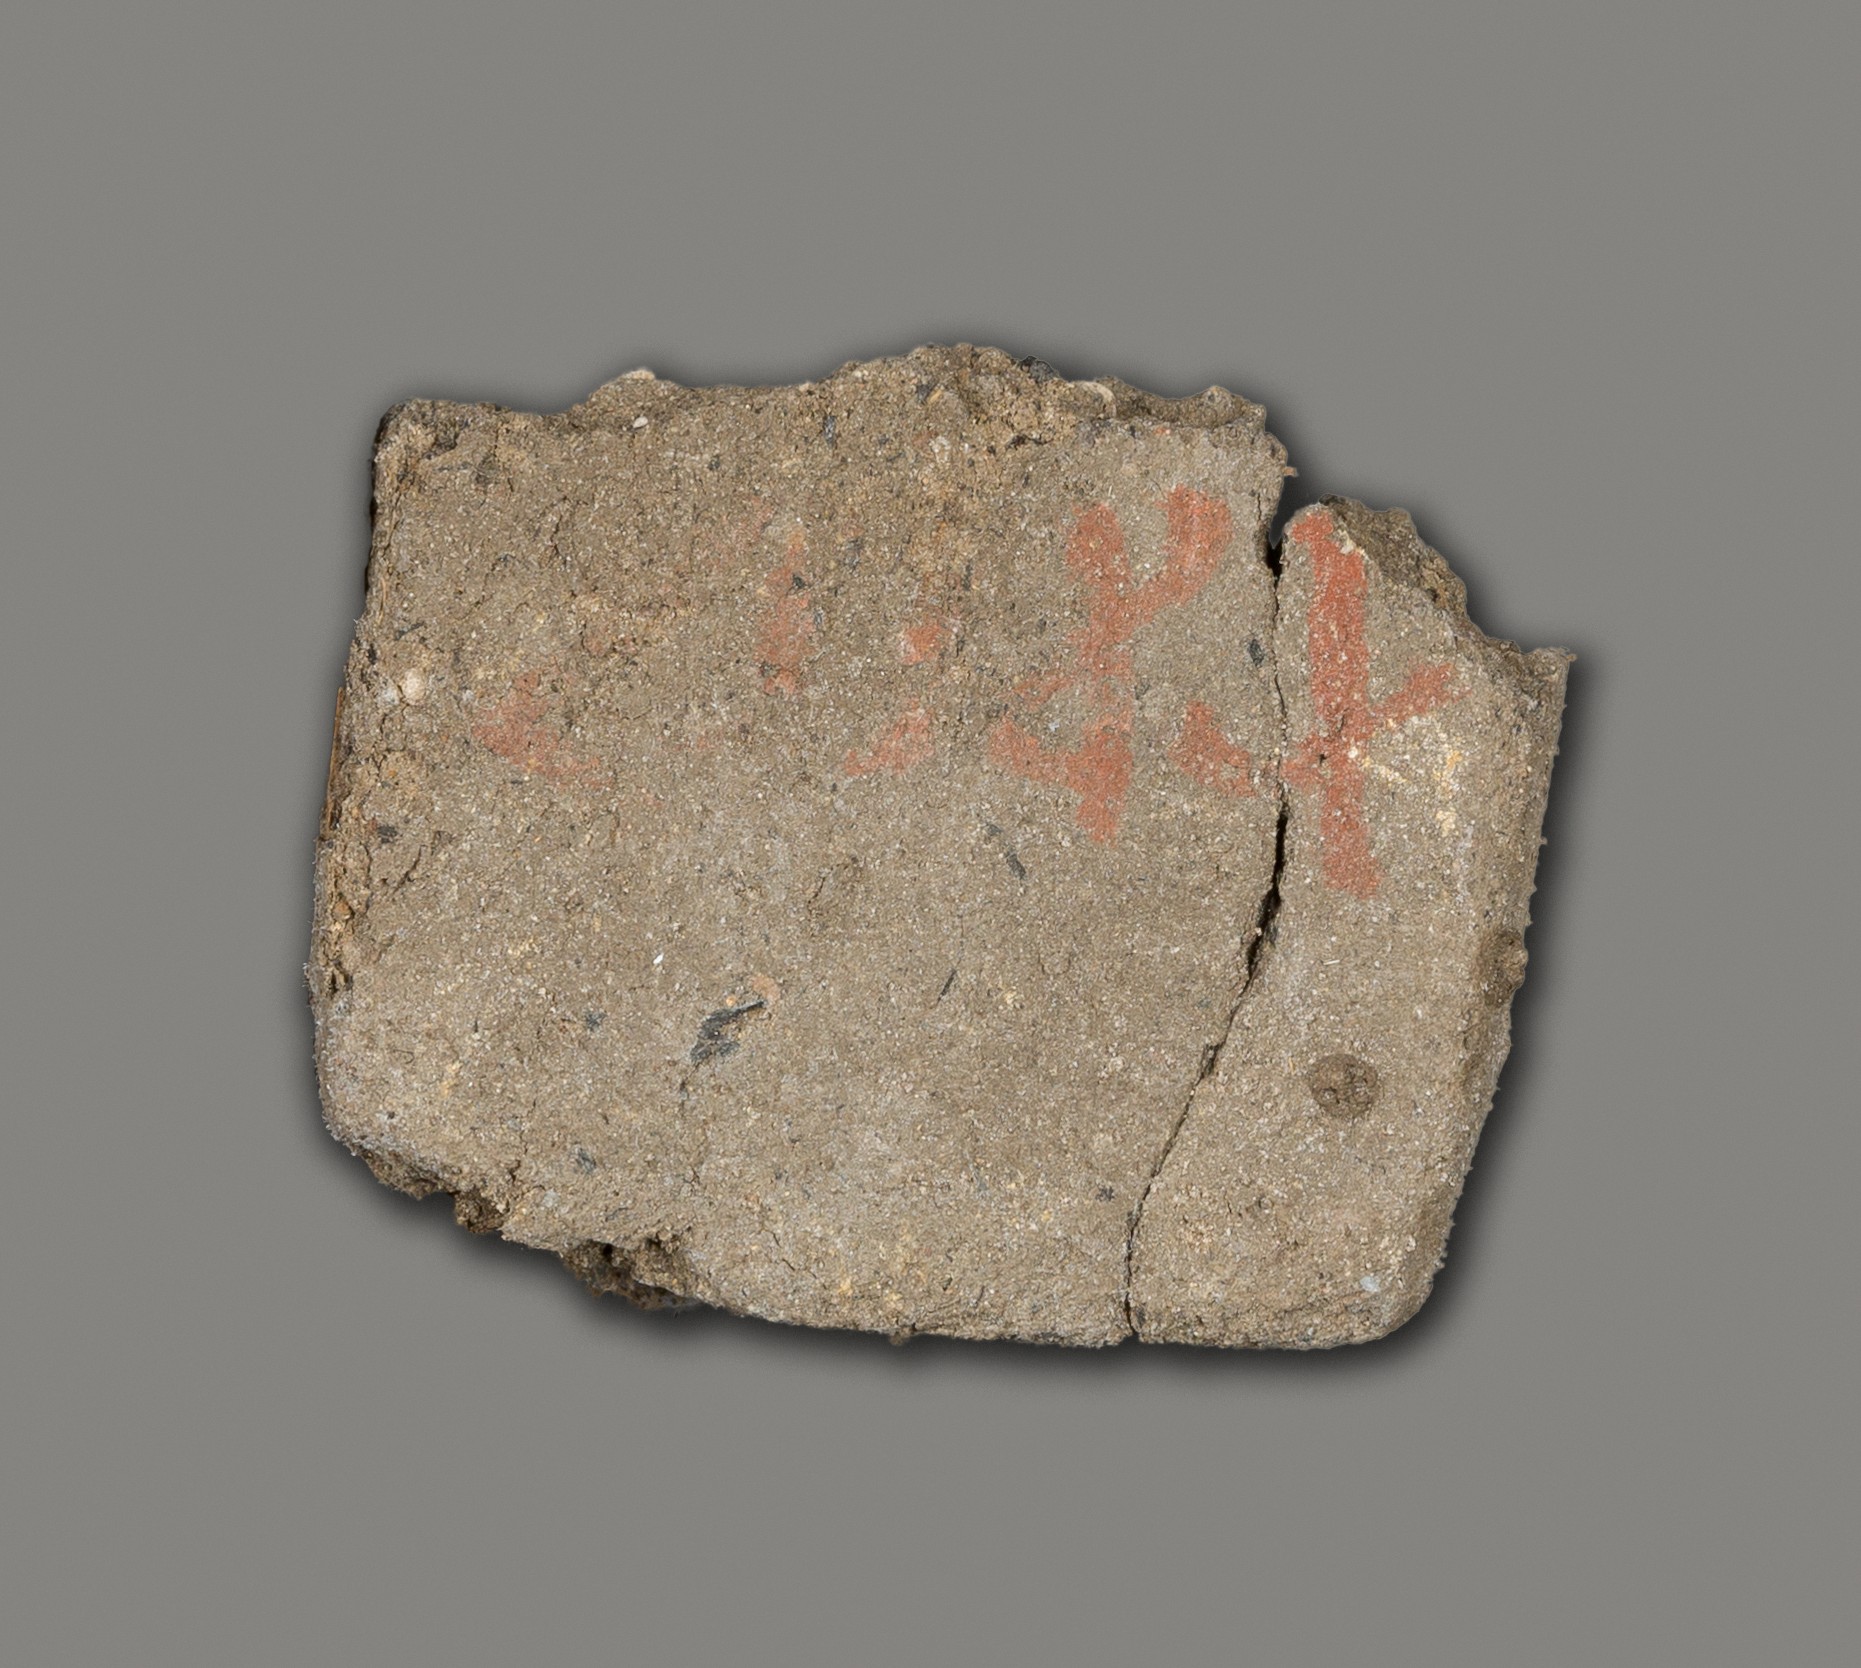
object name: figure, magical, execration, tablet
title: Magical Figure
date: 1802-1550 BCE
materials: clay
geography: egypt